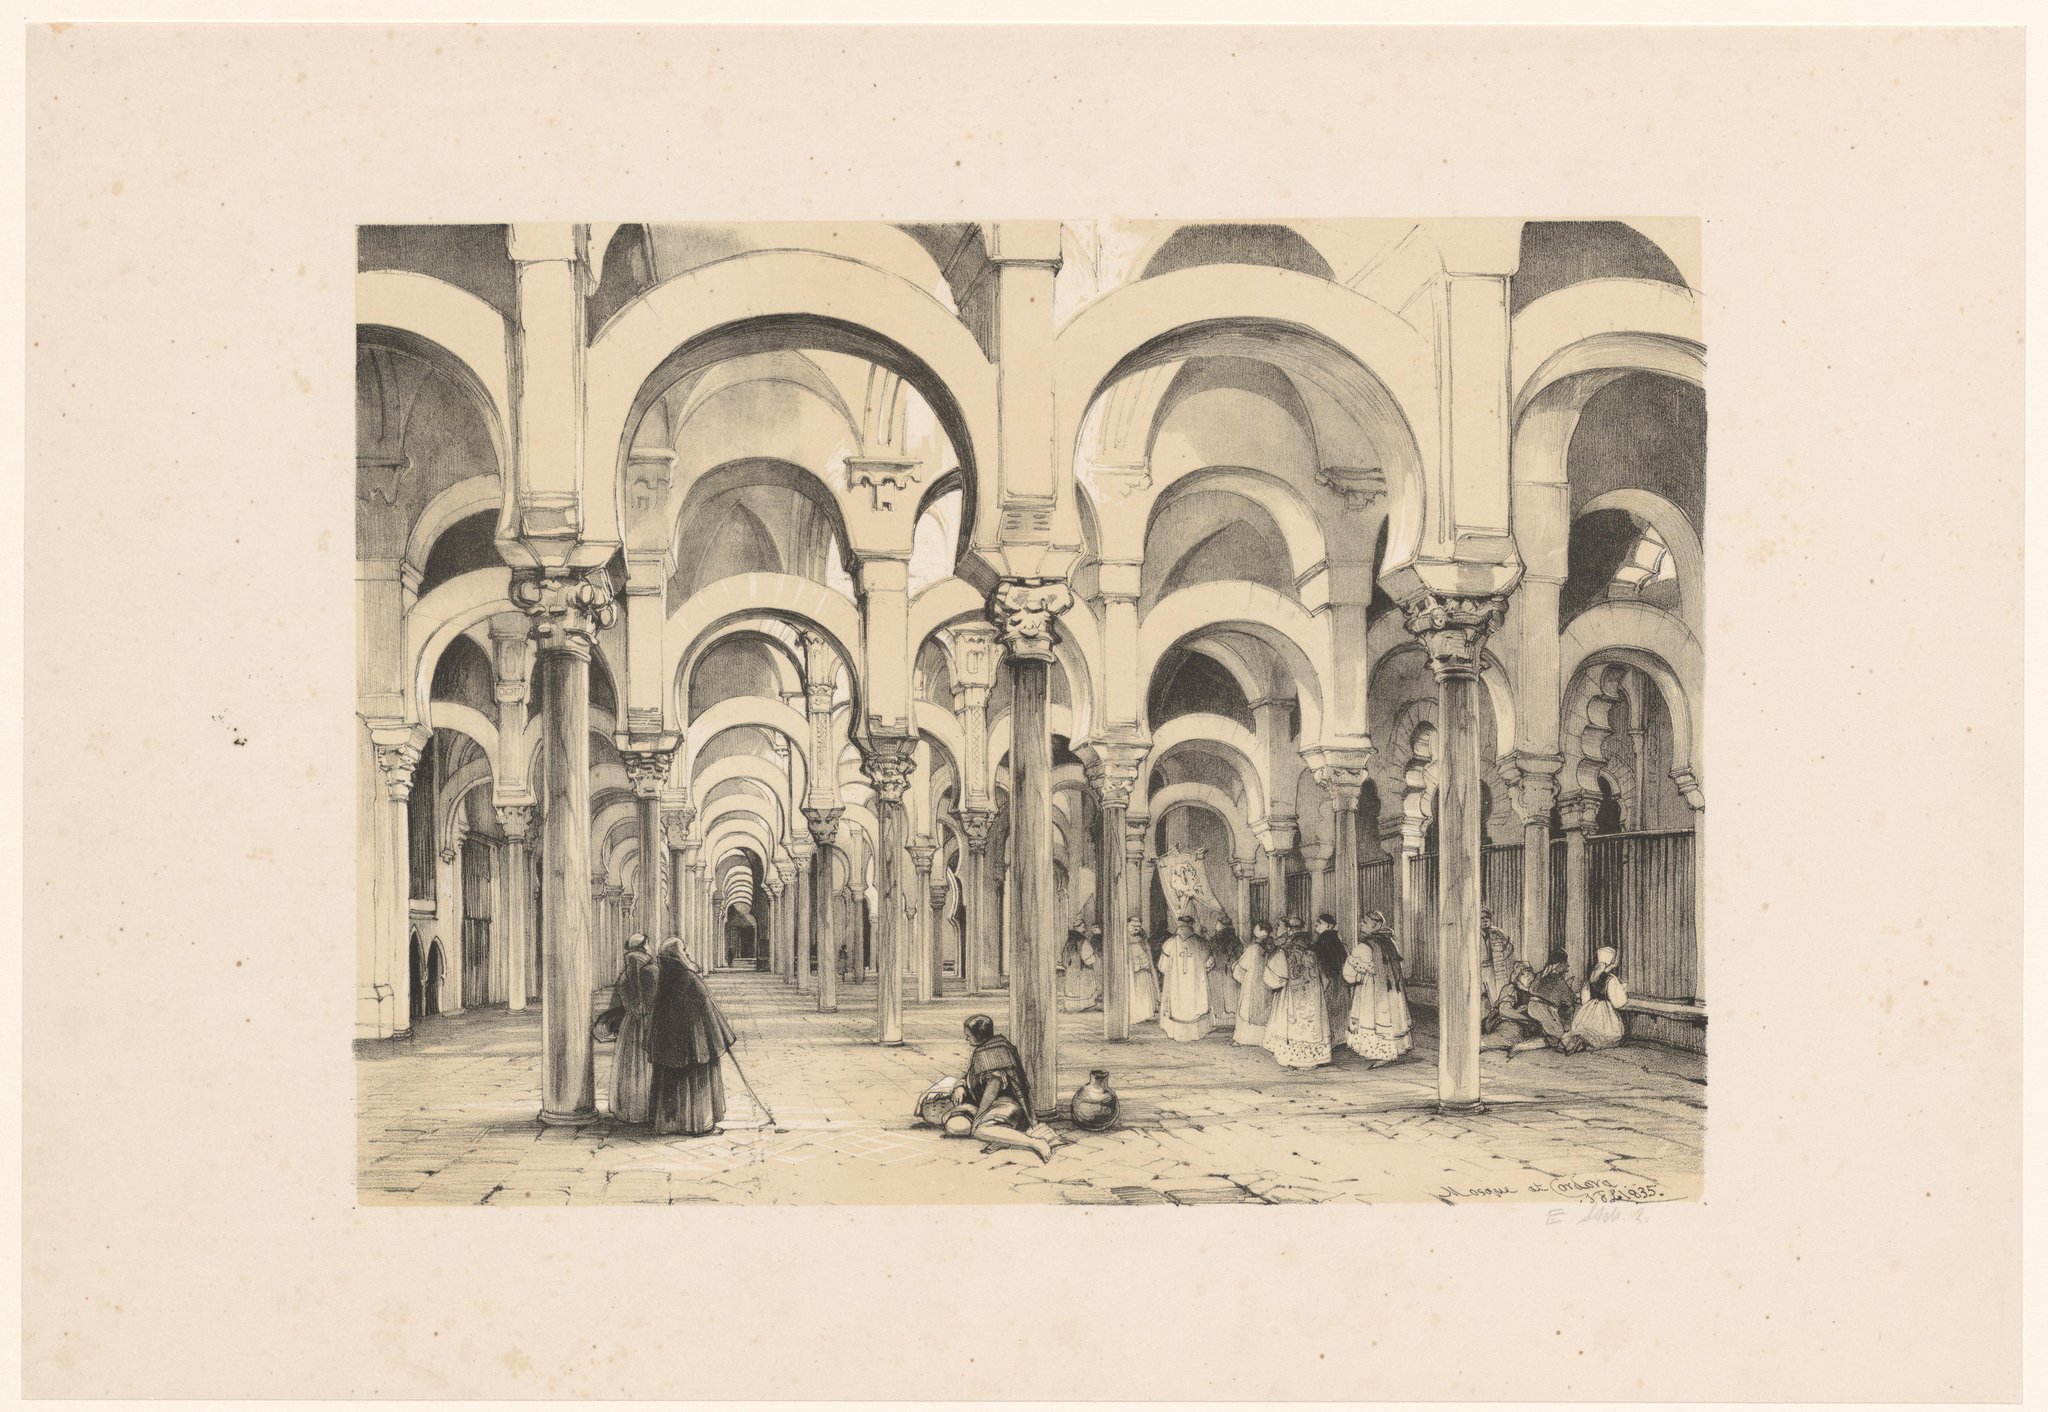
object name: print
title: Mosque at Cordova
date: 1836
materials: paper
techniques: tone lithography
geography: london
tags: interior of church, temple, shrine ~ islam, mohammedanism, organization, functionaries and dignitaries in roman catholic church; clergy in general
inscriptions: collector's mark: Lugt 2228